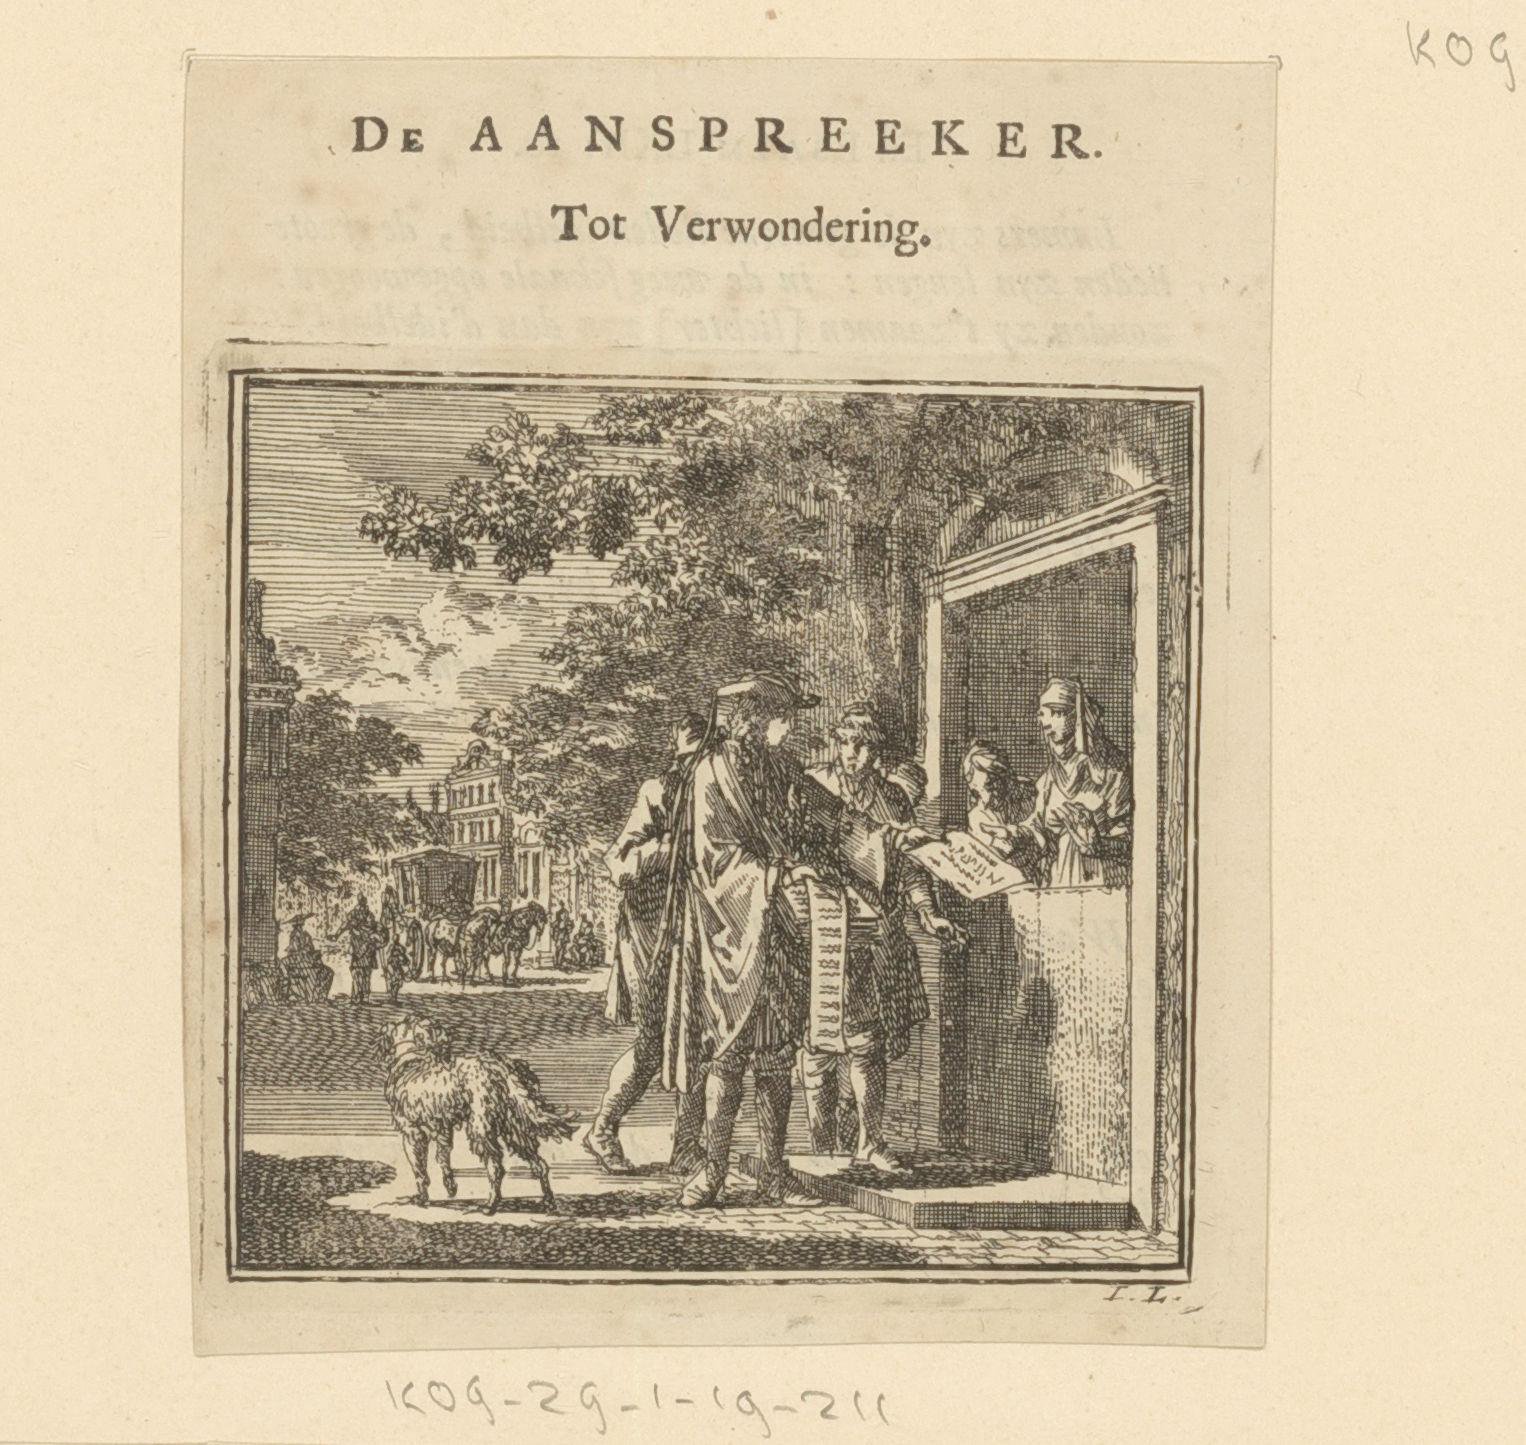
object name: print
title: De Aanspreeker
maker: jan luyken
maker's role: draughtsman, print maker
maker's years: 1649-1712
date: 1711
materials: paper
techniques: etching, letterpress printing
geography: amsterdam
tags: oral announcement (of death), undertaker's man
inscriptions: collector's mark: Lugt 1641, collector's mark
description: Een aanspreker reikt een vrouw een bericht van overlijden aan. Met een spreuk boven de plaat. Onderwerpsrubrieken binnen de Atlas Zeden en Gewoonten: Des Menschen Begin, Midden en Einde. Begrafenissen, aansprekers, doodgravers, enz.